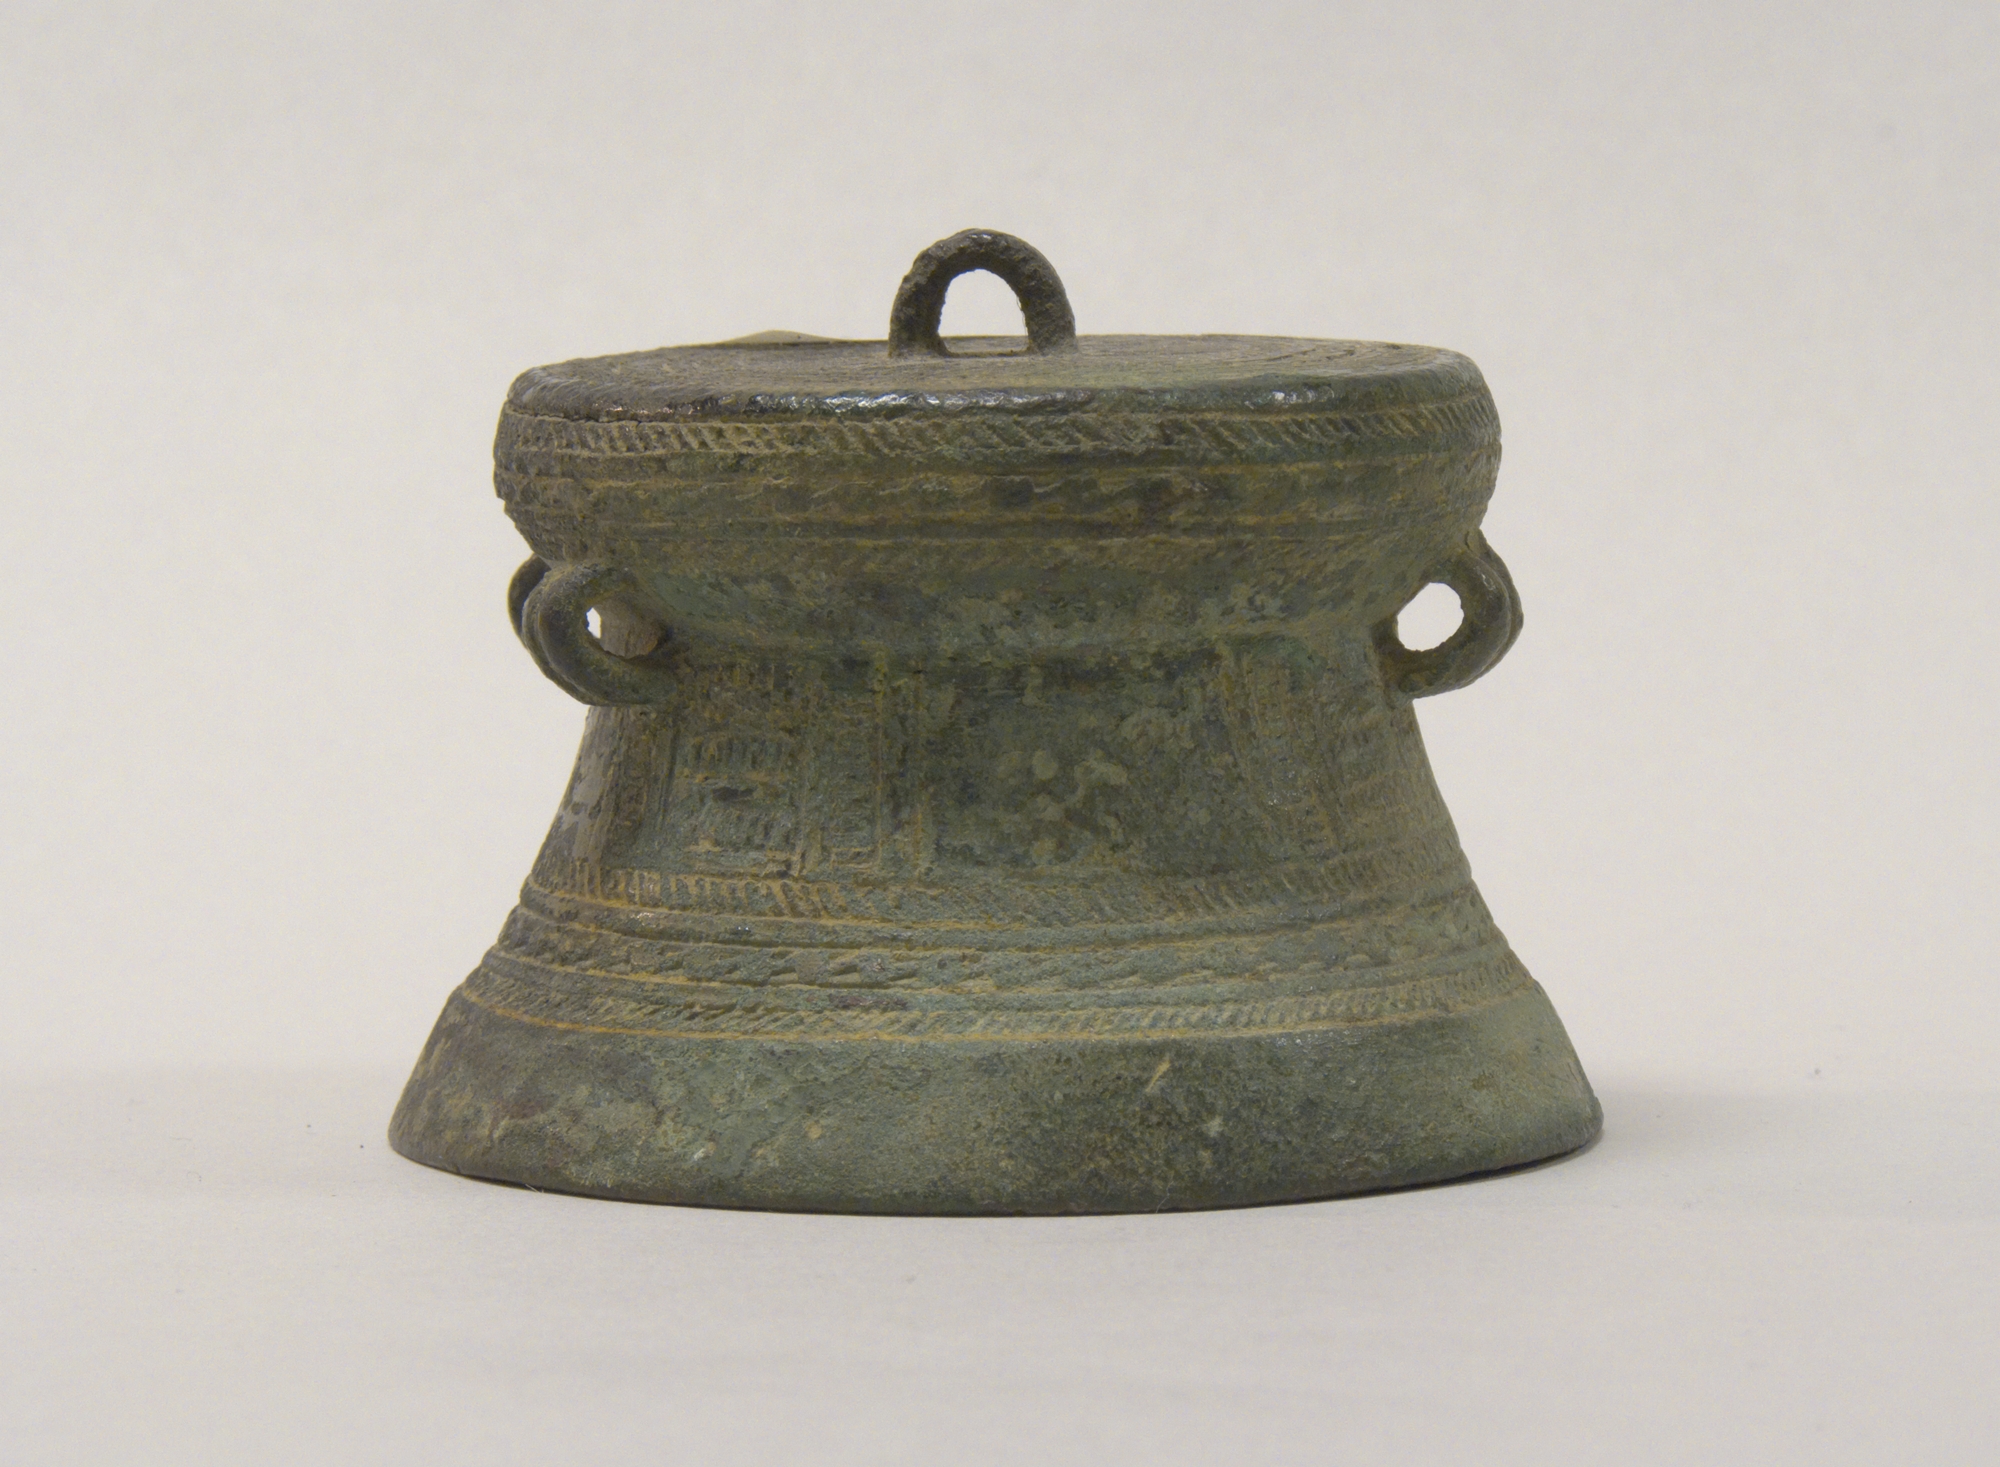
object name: drum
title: Small Drum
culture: vietnamese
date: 500 BCE-300 CE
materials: bronze